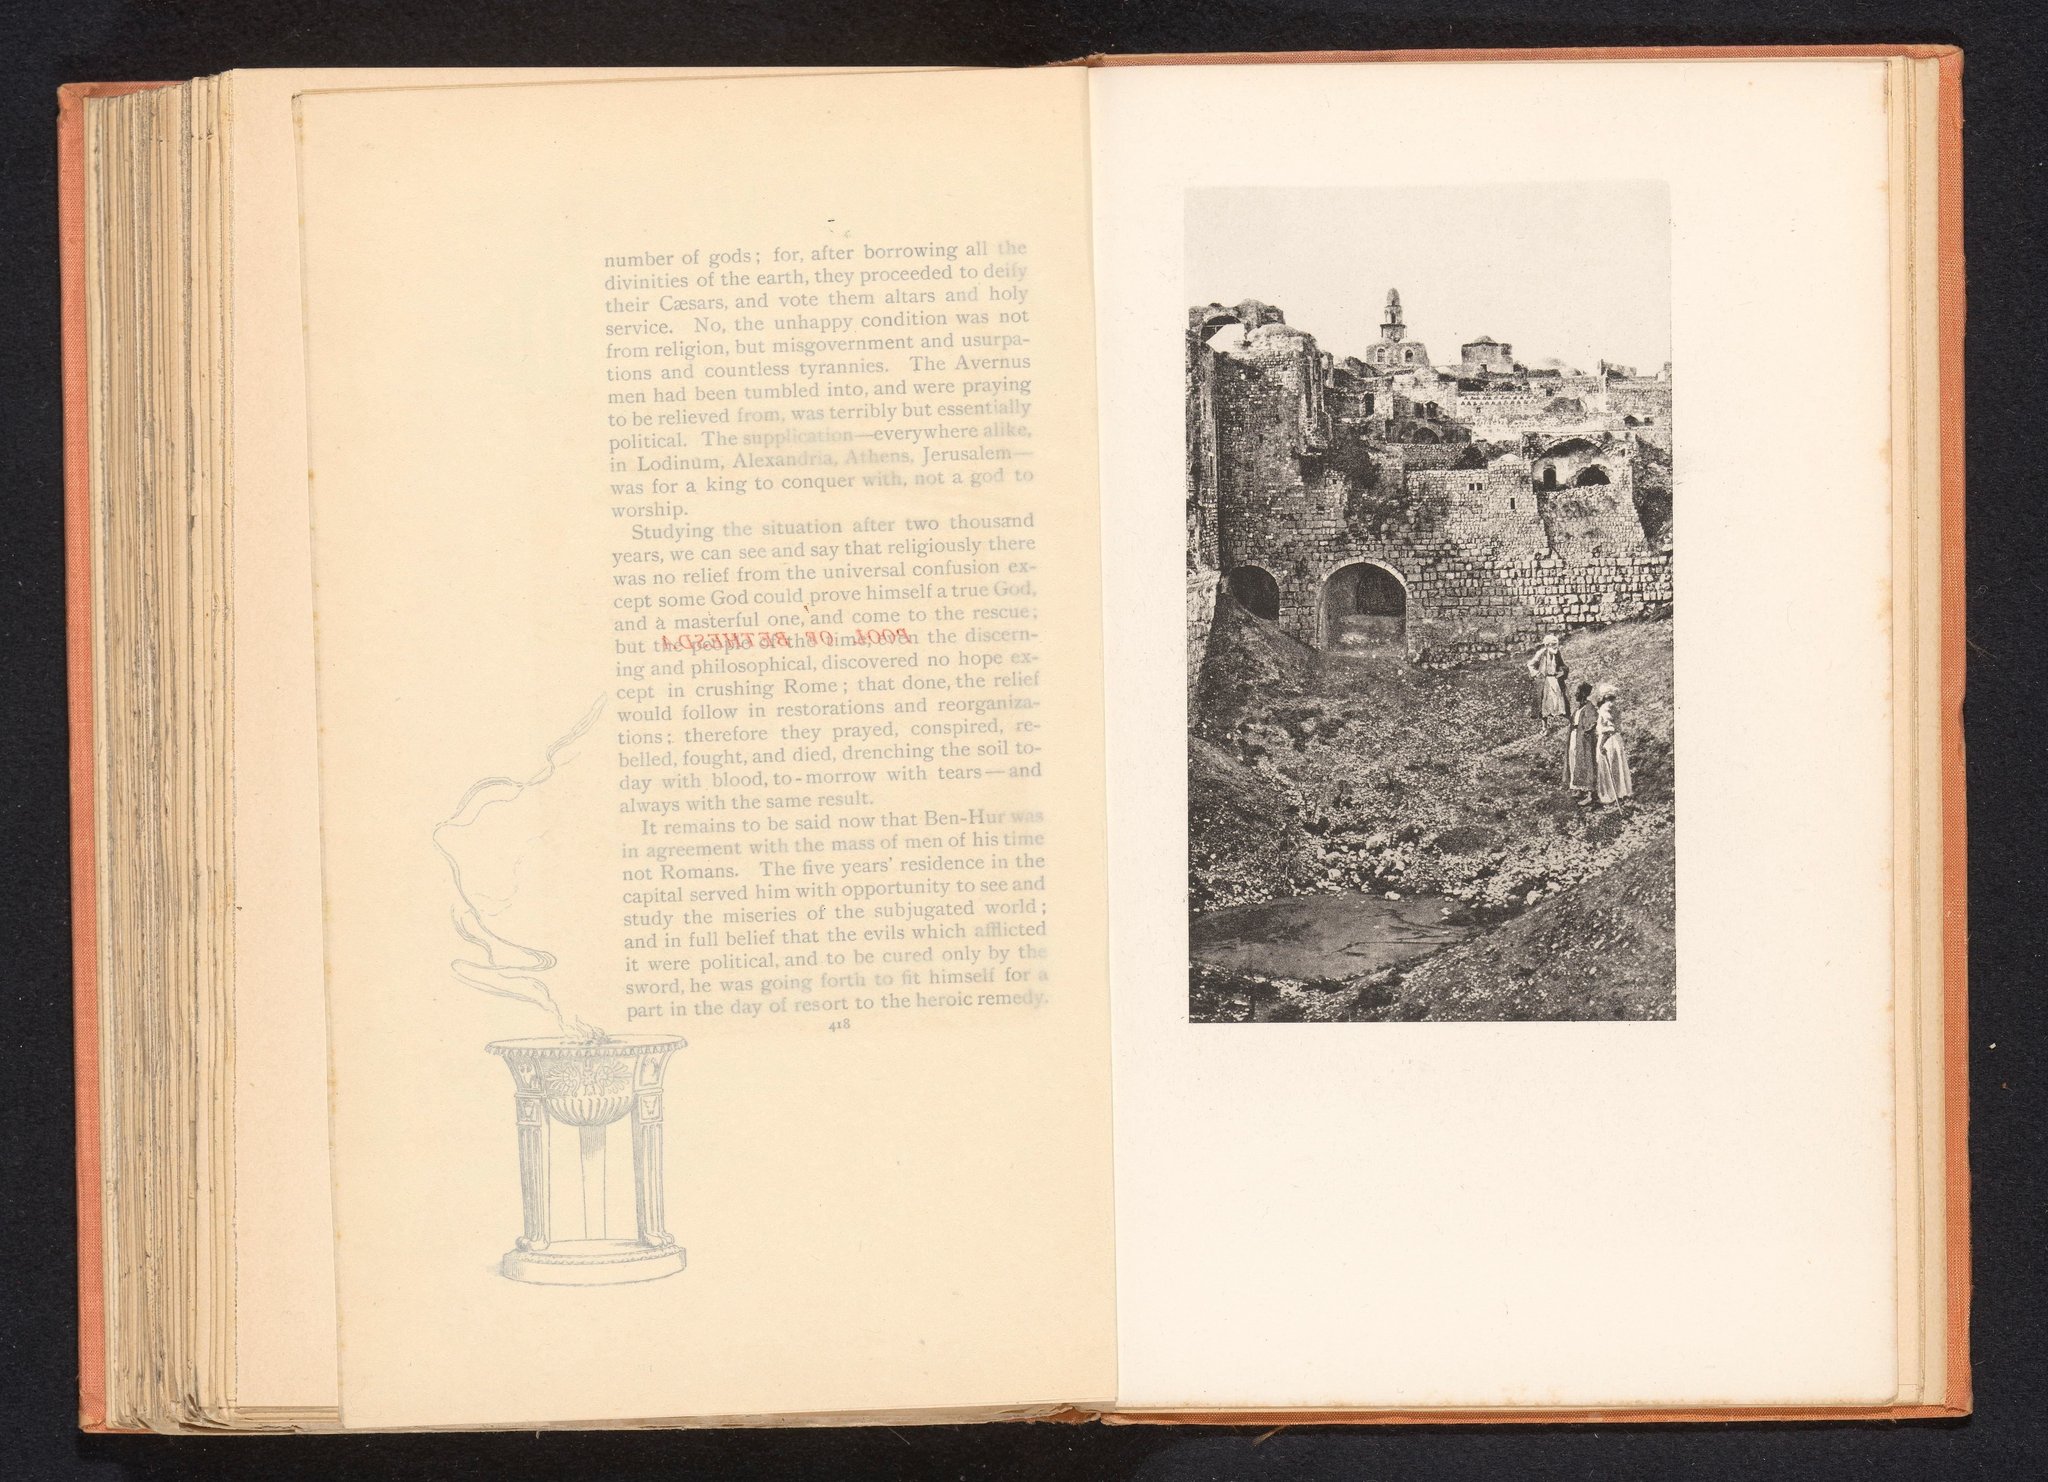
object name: page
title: Gezicht op de poel van Bethesda in Jeruzalem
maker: Anonymous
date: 1882-1892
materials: paper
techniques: photoaquatint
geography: jerusalem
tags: pond, pool